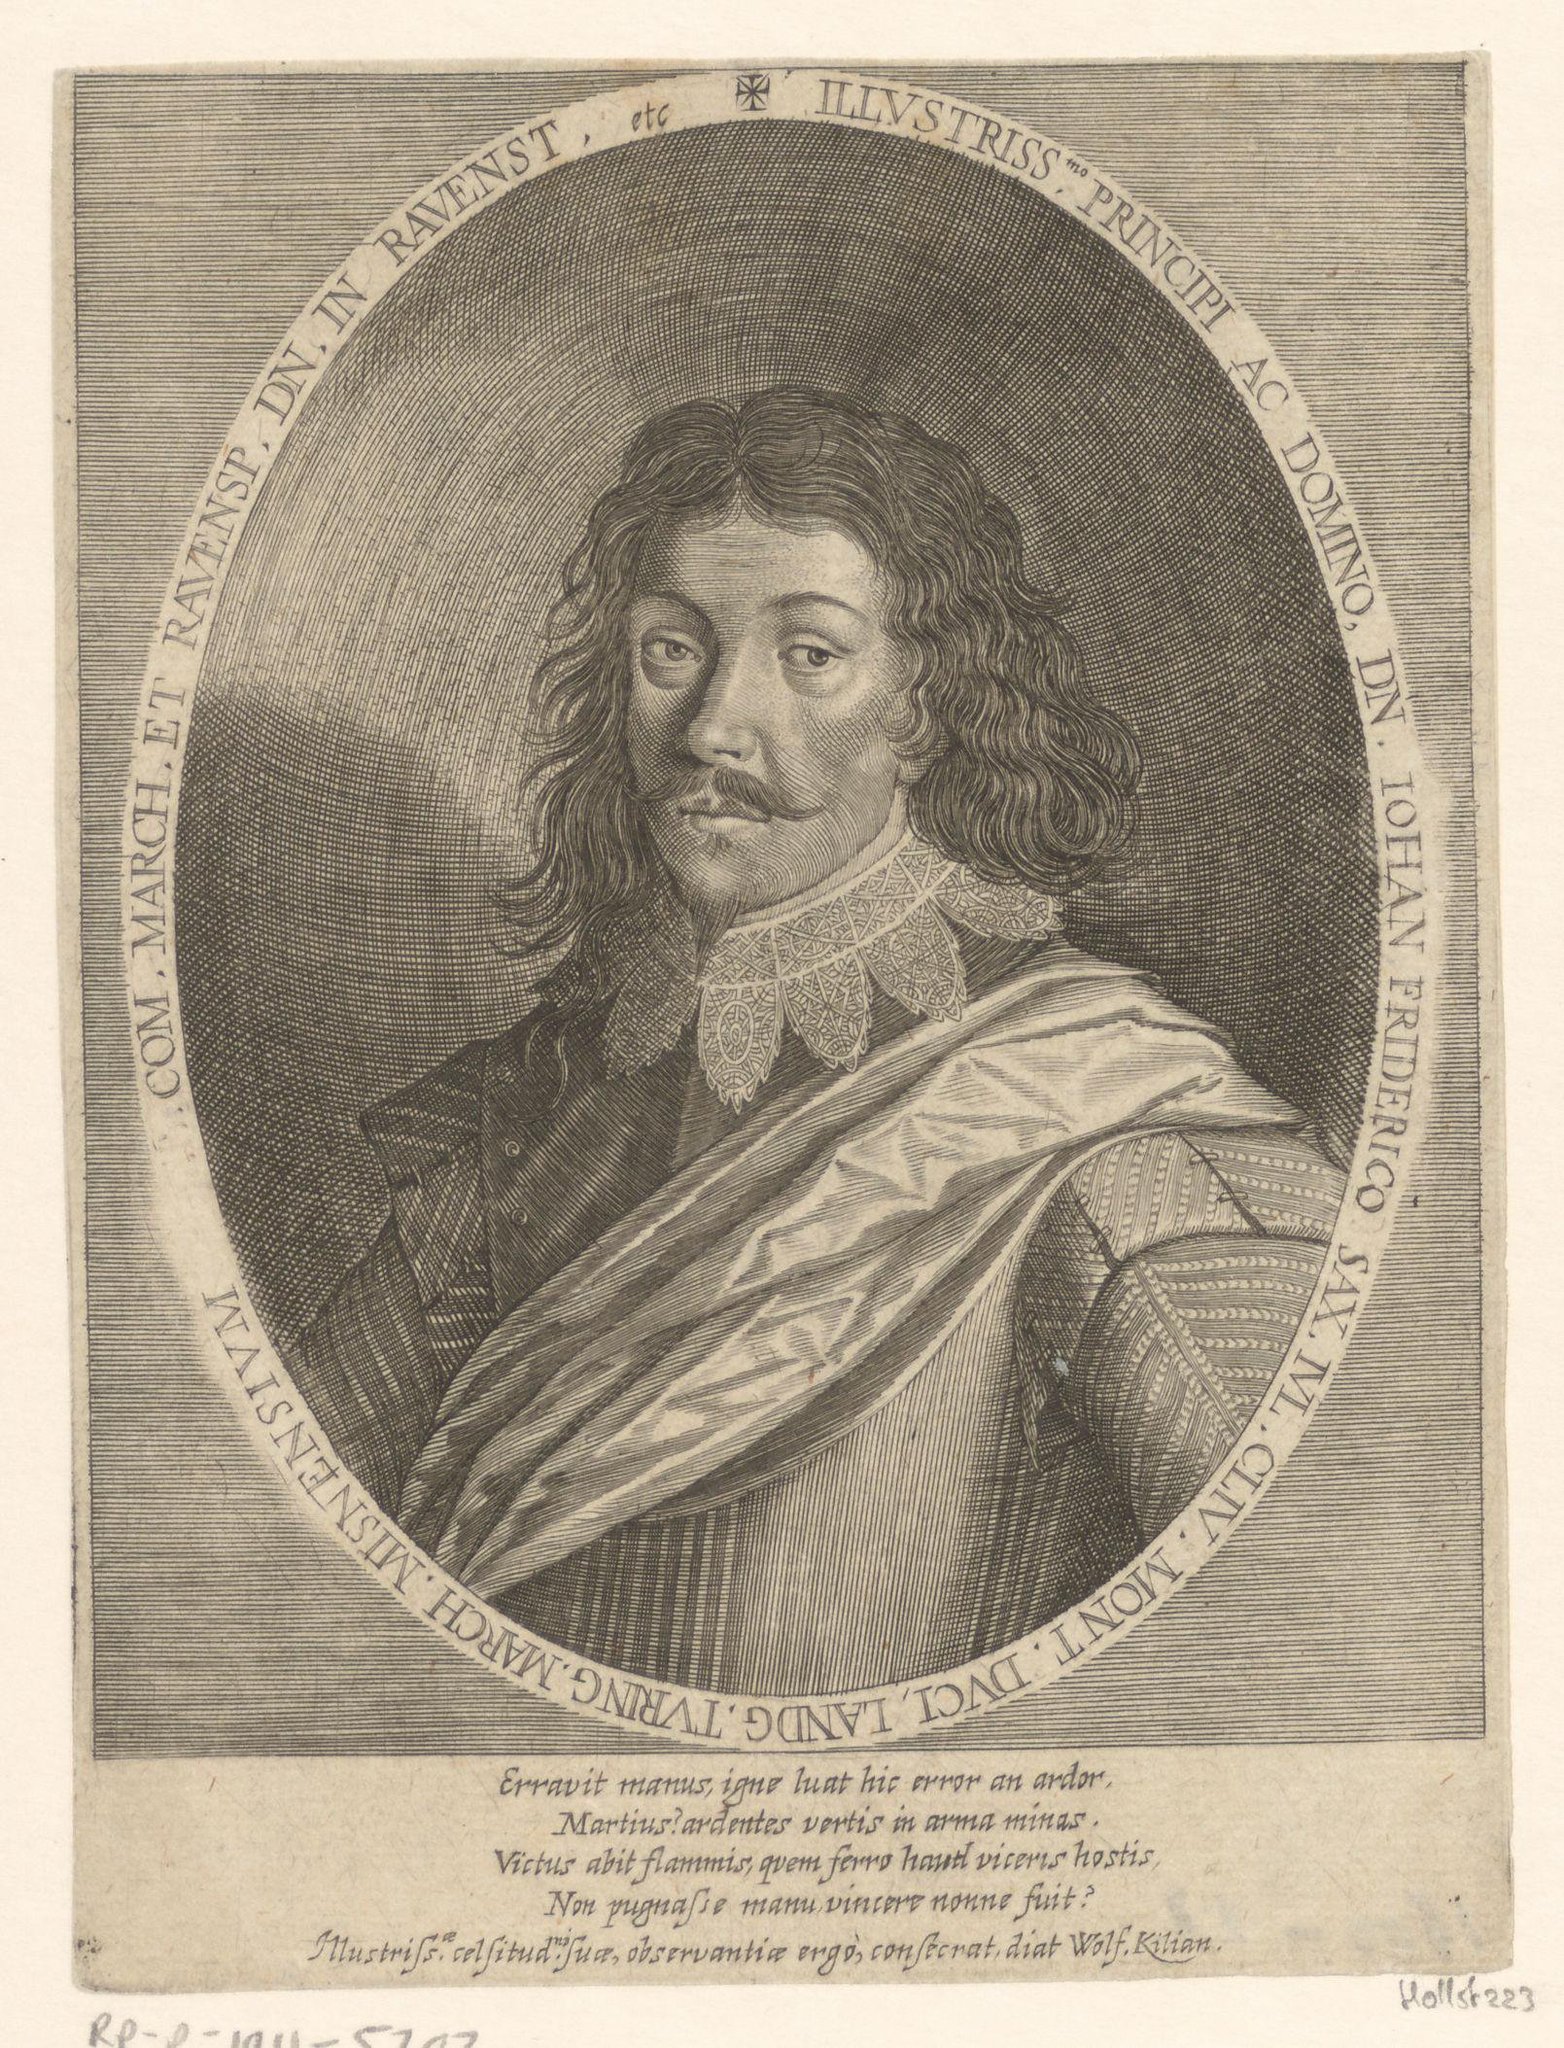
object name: print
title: Portret van Johann Friedrich van Saksen-Weimar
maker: wolfgang kilian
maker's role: print maker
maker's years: 1581-1662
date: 1610-1662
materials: paper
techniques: engraving, etching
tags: historical persons, officer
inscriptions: collector's mark: Lugt 2228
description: Tekst in het Latijn in de omlijsting en in de ondermarge.